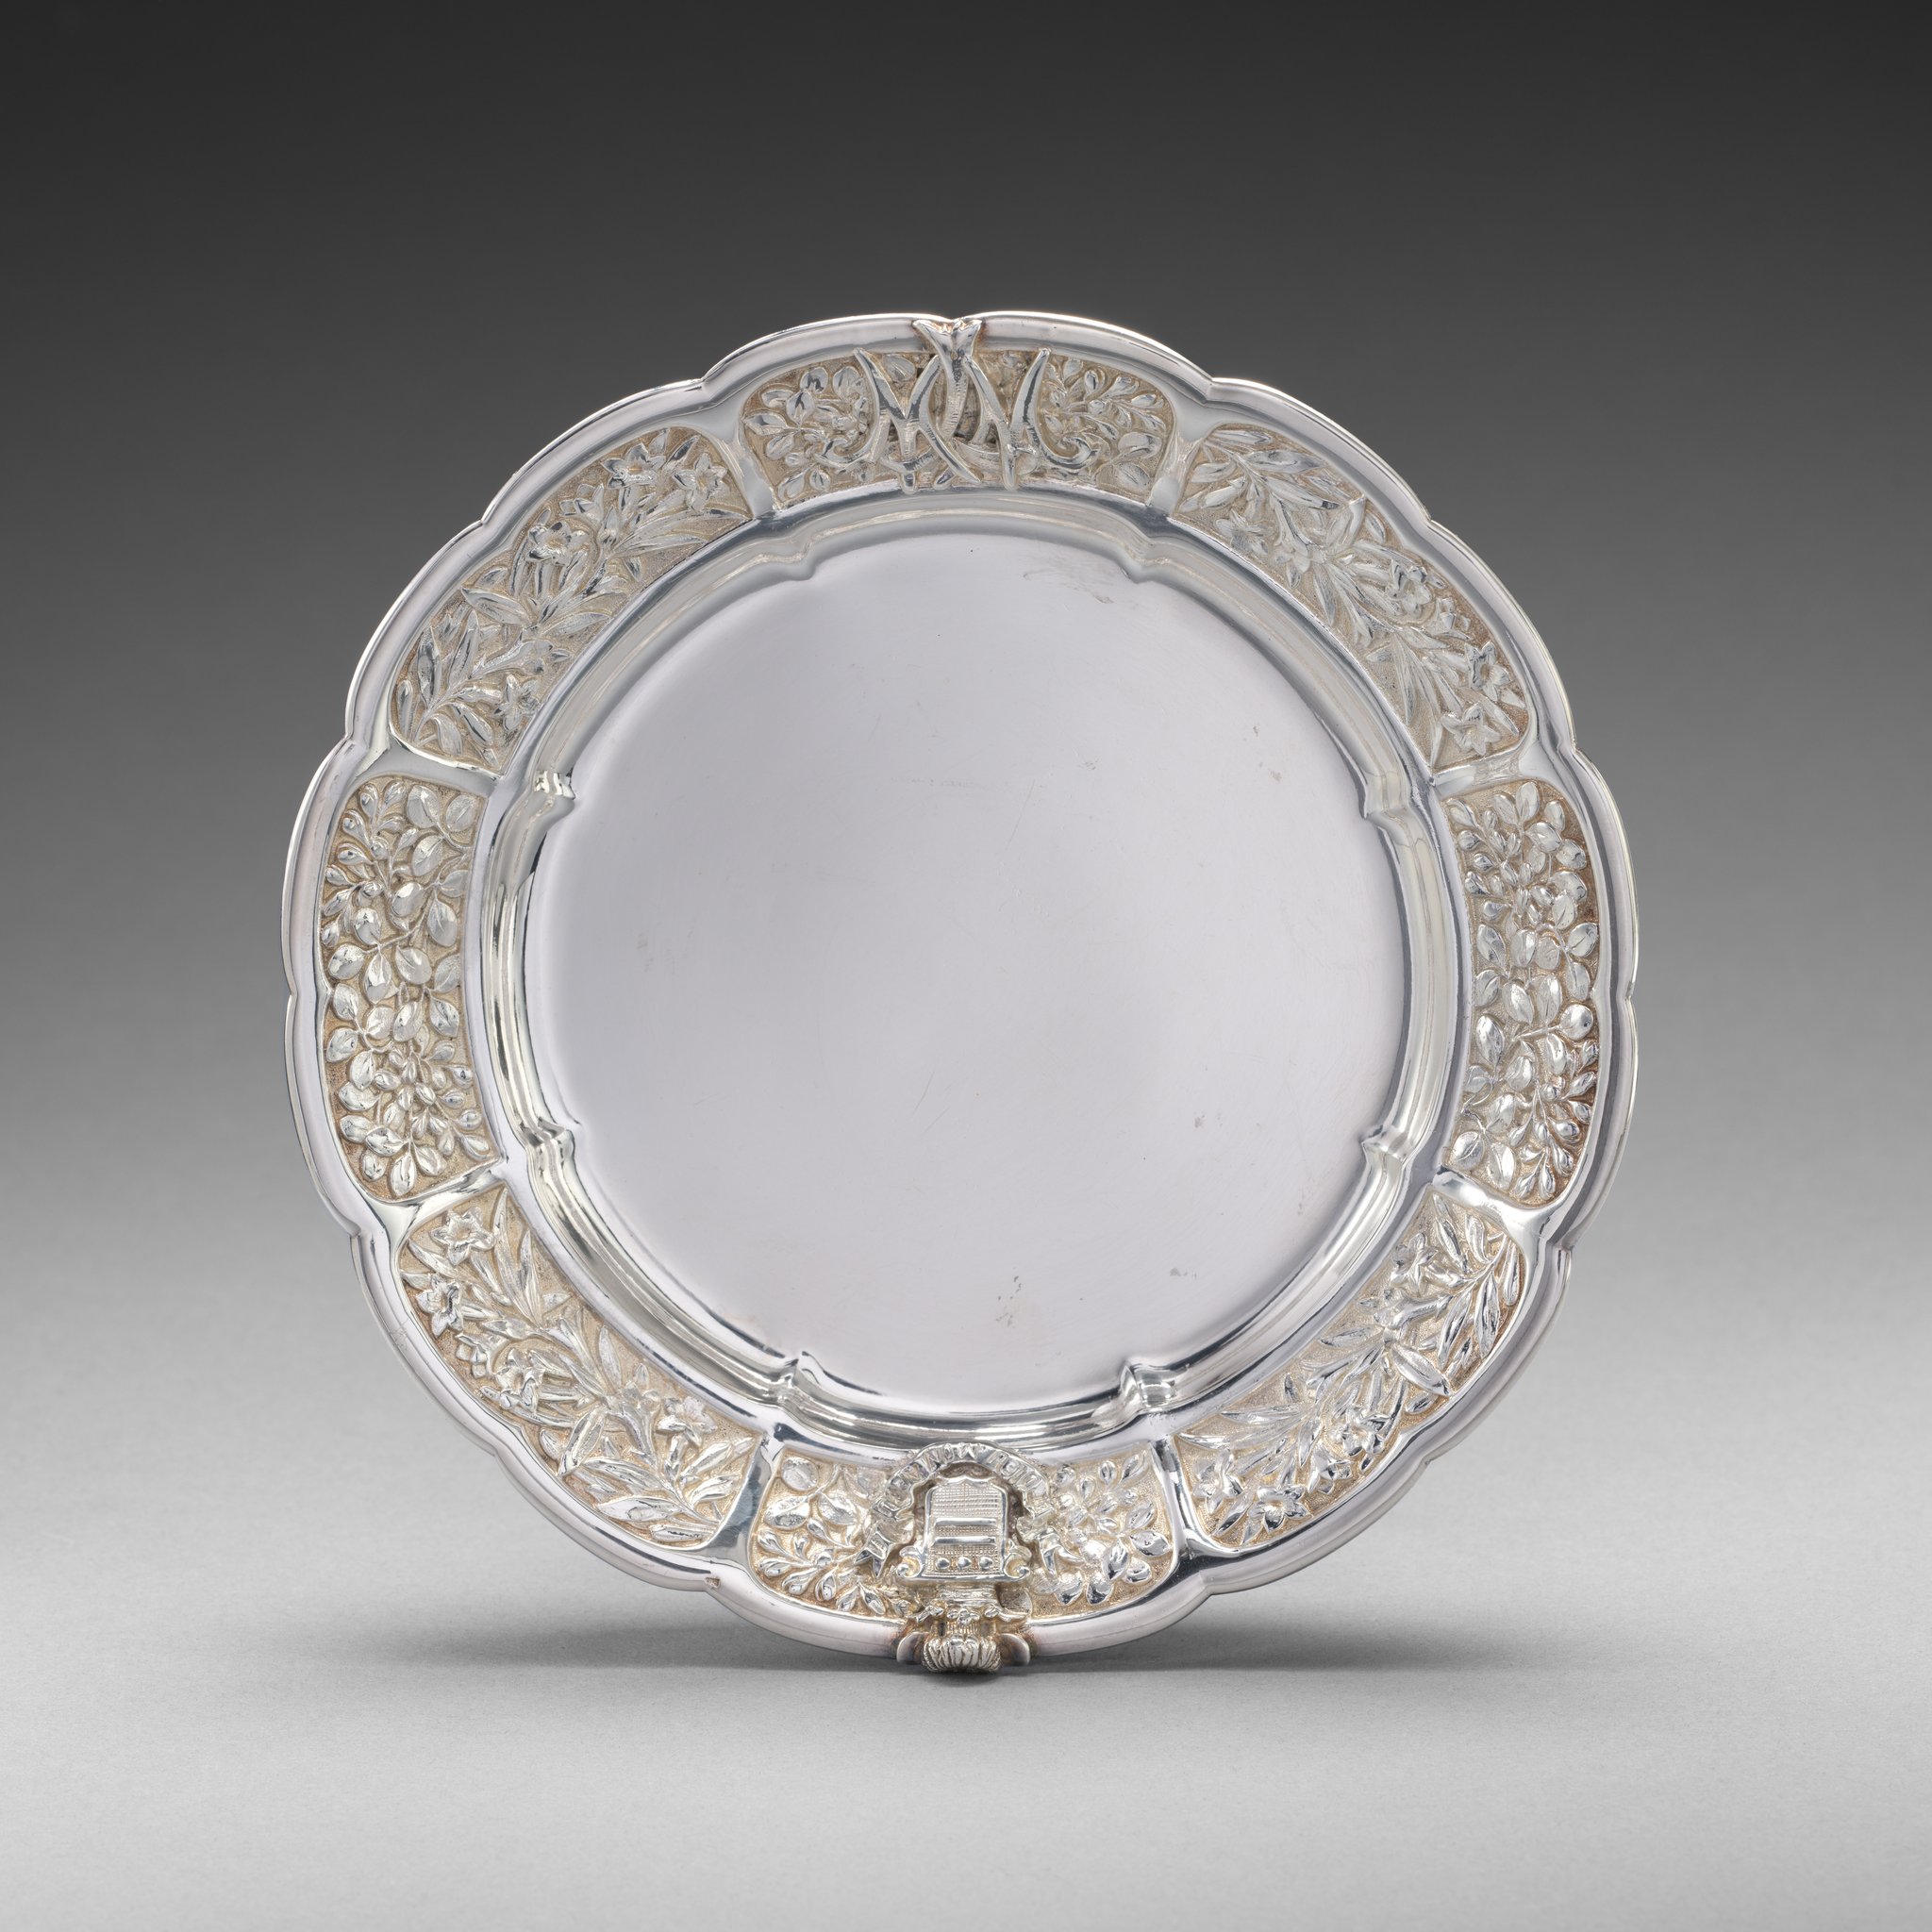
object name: ice cream plate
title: Ice Cream Plate from Mackay Service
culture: american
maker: tiffany & co.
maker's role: maker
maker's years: 1837-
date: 1878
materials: silver